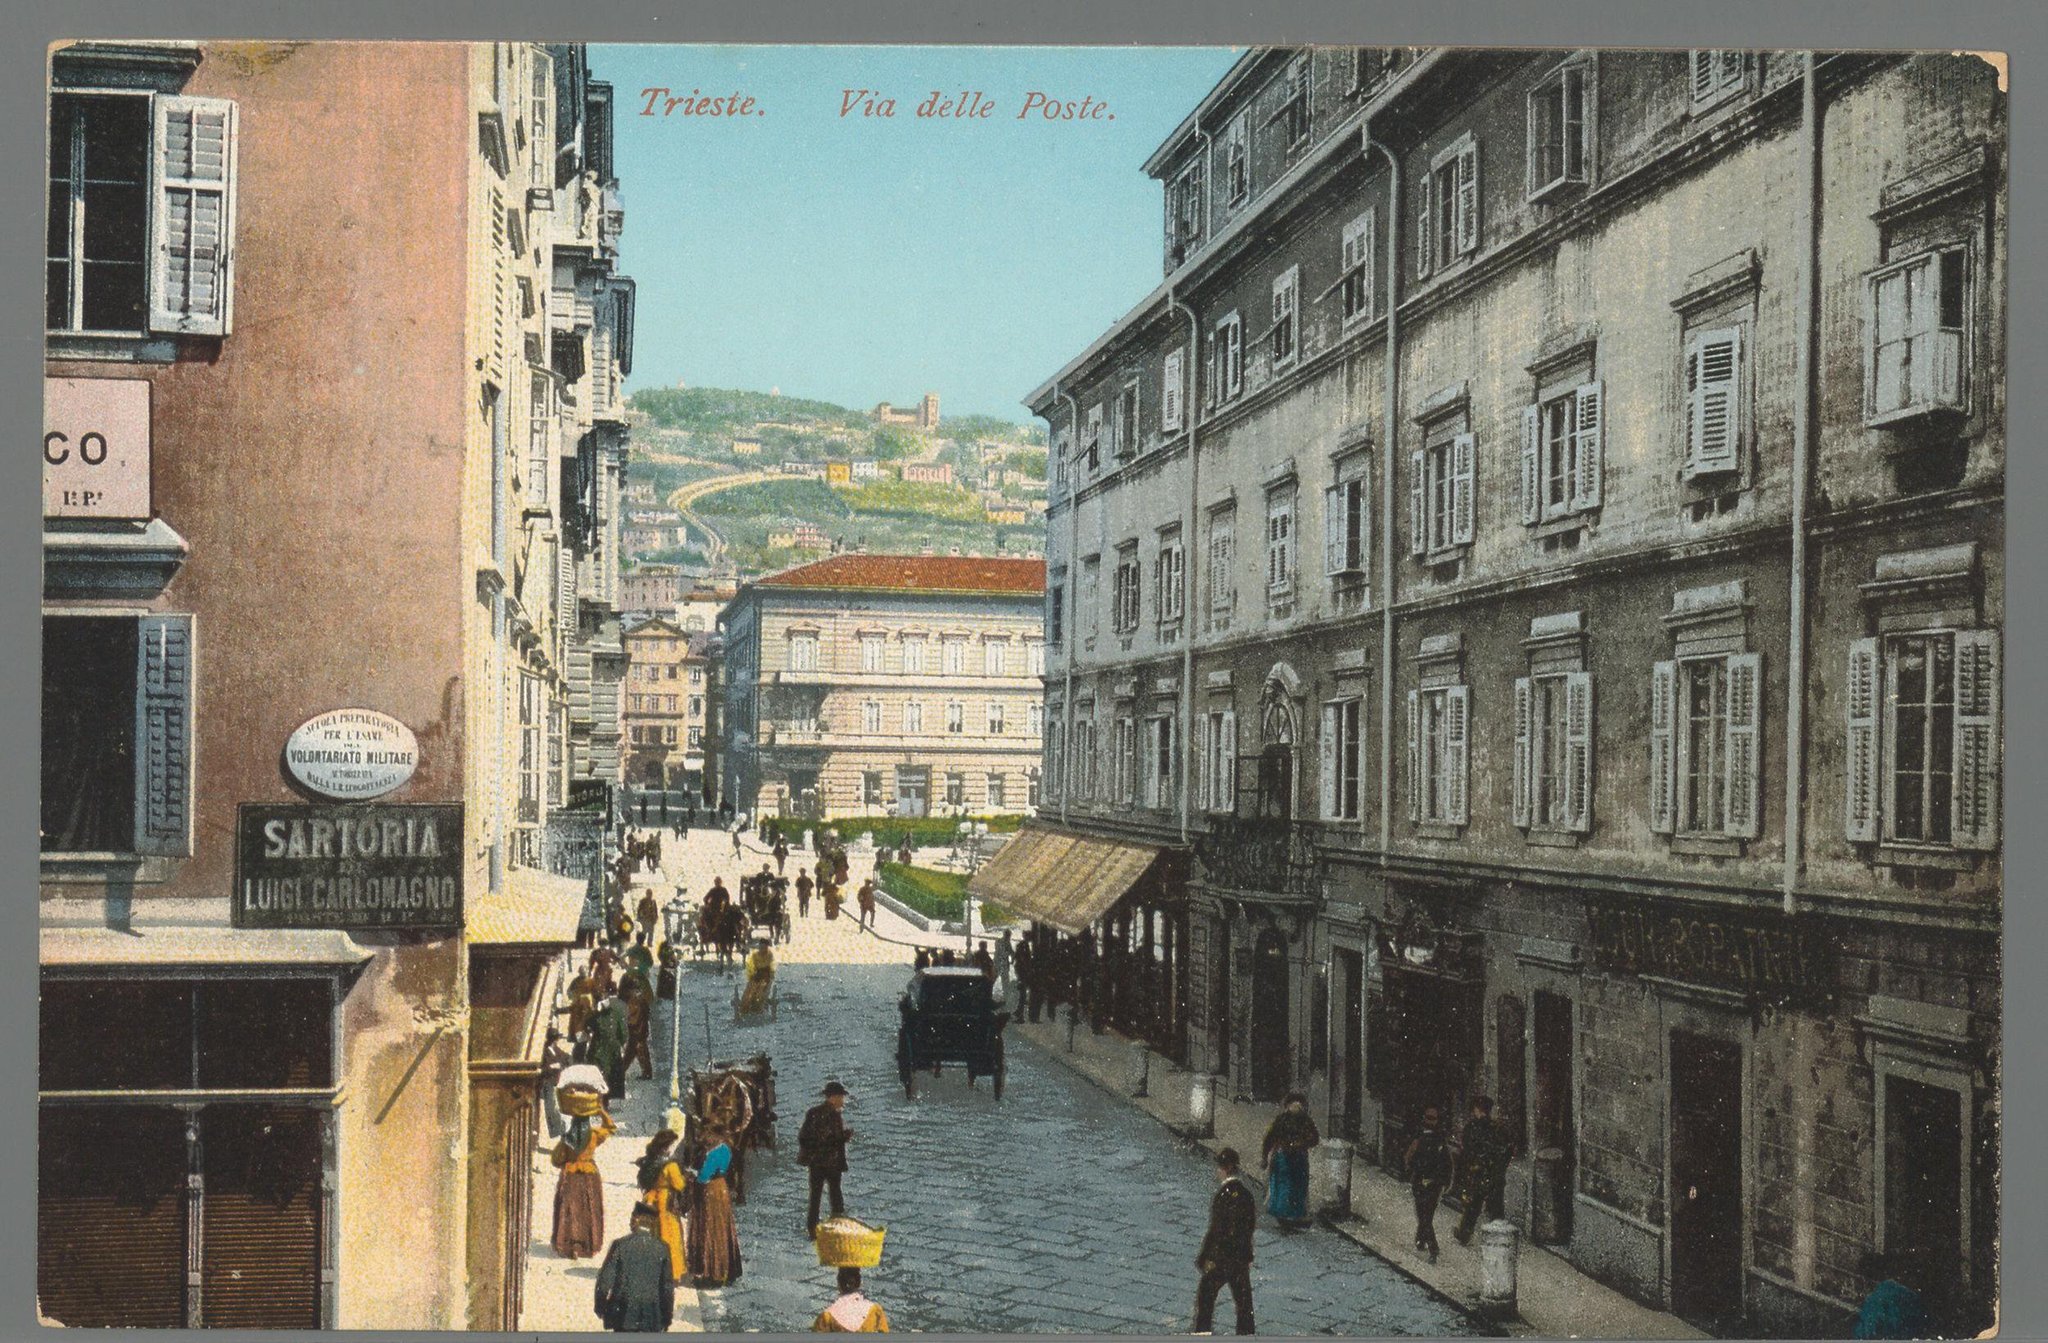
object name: photomechanical print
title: Trieste. Via delle Poste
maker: Anonymous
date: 1906-1909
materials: cardboard, photographic process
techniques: writing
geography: munich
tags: urban housing, street (+ city(-scape) with figures, staffage)